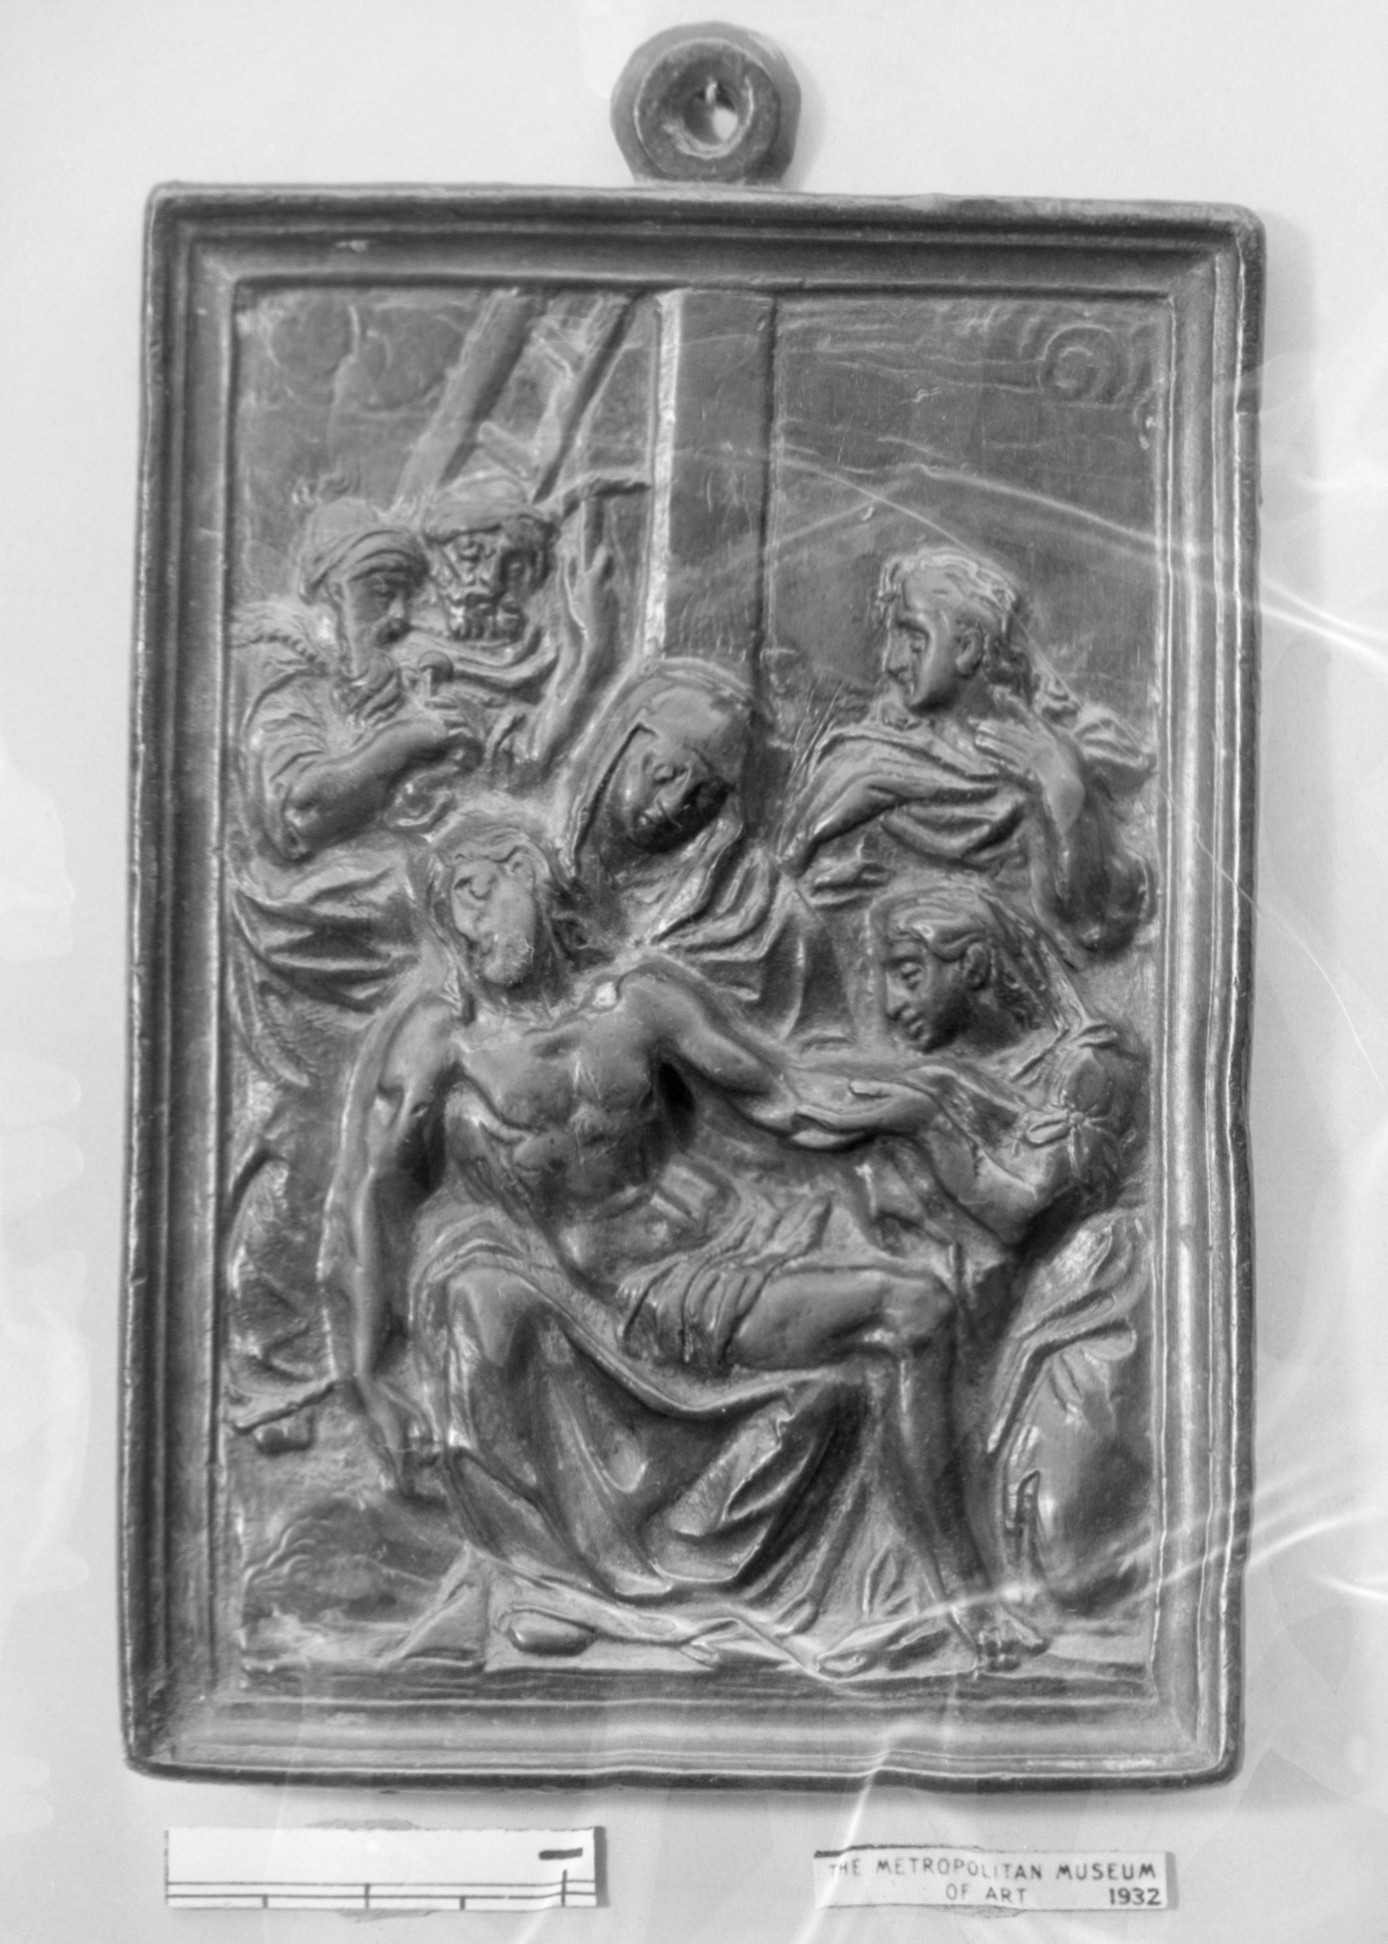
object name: plaquette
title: Pietà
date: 1567-1600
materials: bronze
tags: men,women,virgin mary,jesus